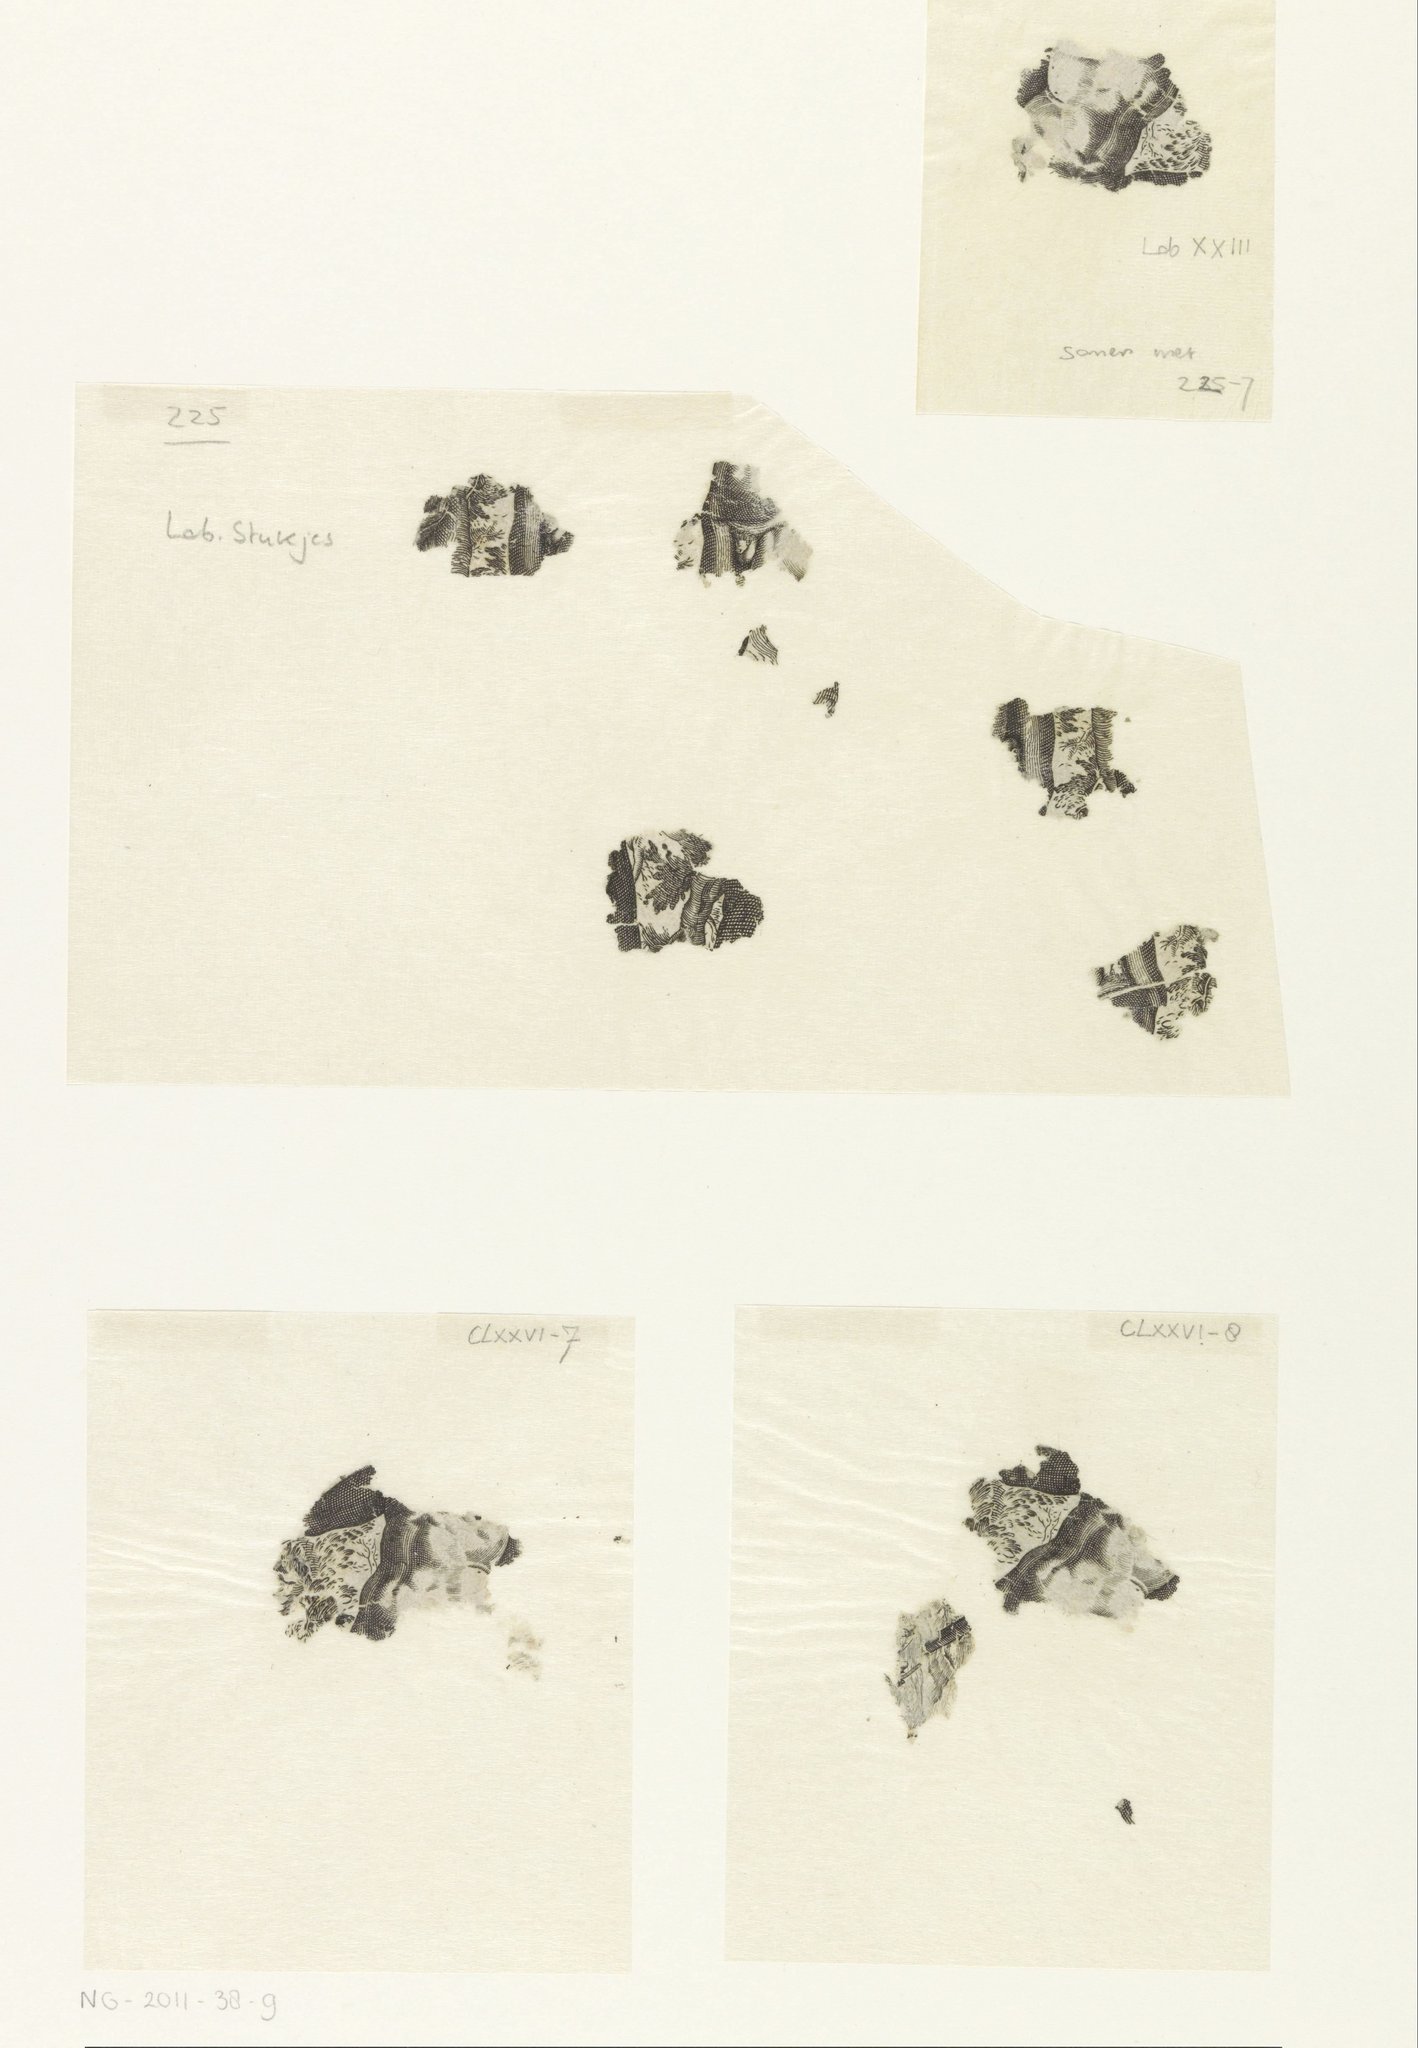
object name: print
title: Losse fragmenten van een prent van Adam en Eva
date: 1585-1596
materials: paper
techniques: engraving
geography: northern netherlands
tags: eve takes the fruit from the serpent (or the tree) in the presence of adam (who may be trying to stop her)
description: De prenten in de Nova Zembla collectie zijn tijdens een expeditie van Willem Barendsz en Jacob van Heemskerk in 1596-1597 noodgedwongen in het winterkamp, het ‘Behouden Huis’, op het eiland achtergelaten. De prenten waren in één of meerdere stapels als handelswaar meegenomen vanuit Amsterdam. Bijna drie eeuwen later, in 1871, keerde de Noor Elling Carlsen terug naar Nova Zembla en vond daar de restanten van het ‘Behouden Huis, inclusief een groot deel van de inventaris. Een deel van de prenten, in de vorm van aaneengekoekte kluiten, werd toen ook teruggevonden. De papierkluiten waren soms op meerdere plekken gebroken. Tussen 1975-1979 zijn de prenten van elkaar gescheiden. Dit leverde in totaal ca. 1000 fragmenten van ca. 400 afdrukken van ca. 150 verschillende prenten op. Voor zover mogelijk zijn de fragmenten samengevoegd en zijn de prenten gereconstrueerd.